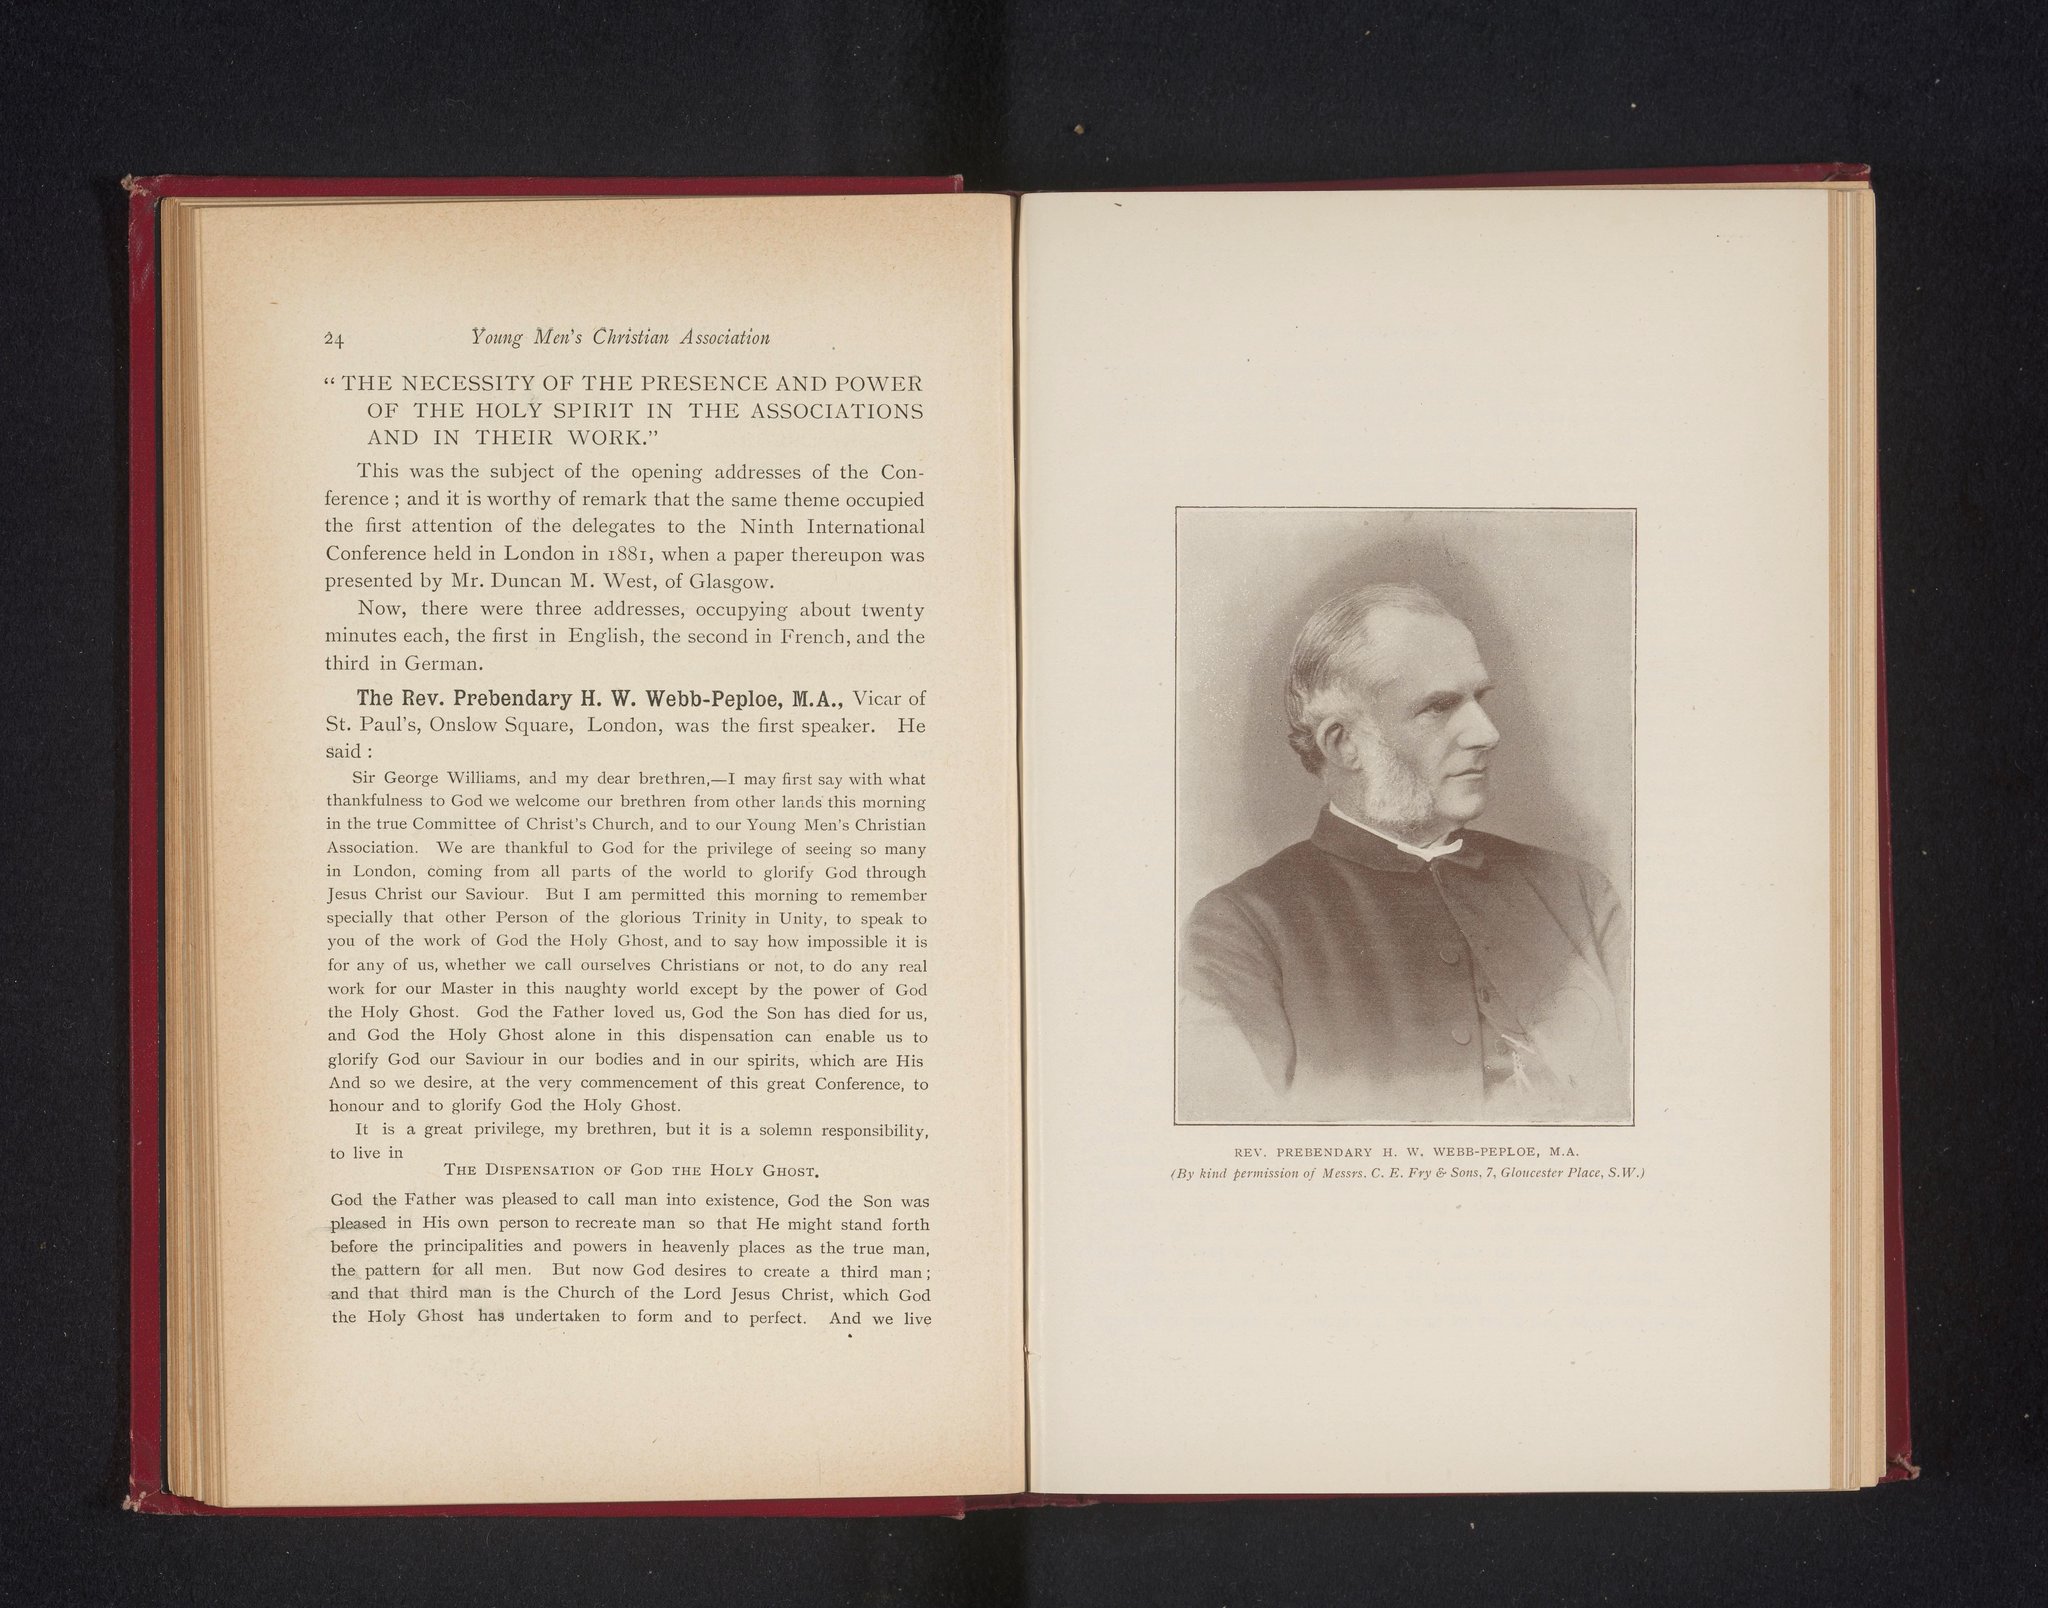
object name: page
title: Rev. Prebendary H. W. Webb-Peploe, M.A.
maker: Anonymous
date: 1890-1895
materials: paper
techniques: autotype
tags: historical persons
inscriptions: inscription: ‘(By kind permission of Messrs. C. E. Fry & Sons, 7, Gloucester Place, S.W.)’